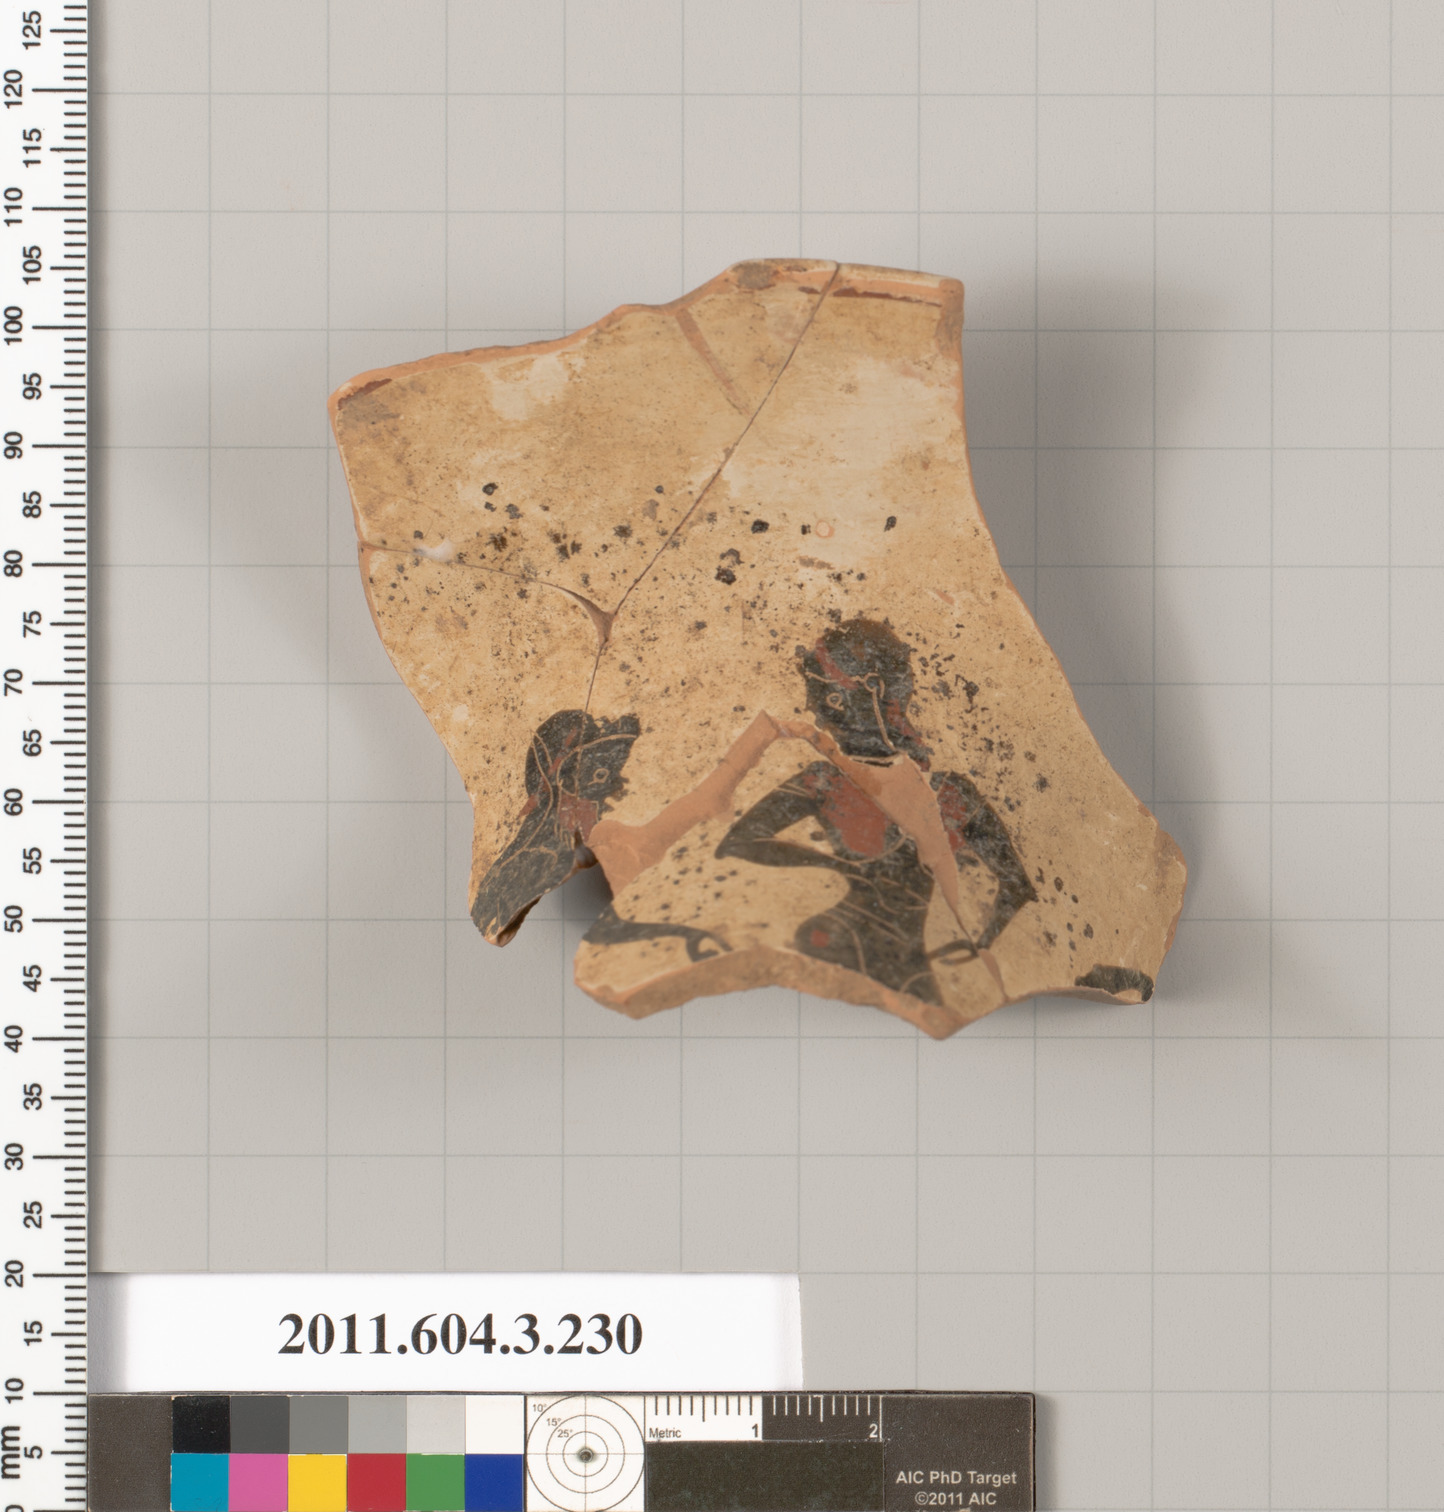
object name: neck amphora fragment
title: Terracotta fragment of a neck-amphora of Nicosthenic shape (jar)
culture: greek, attic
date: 500-468 BCE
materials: terracotta